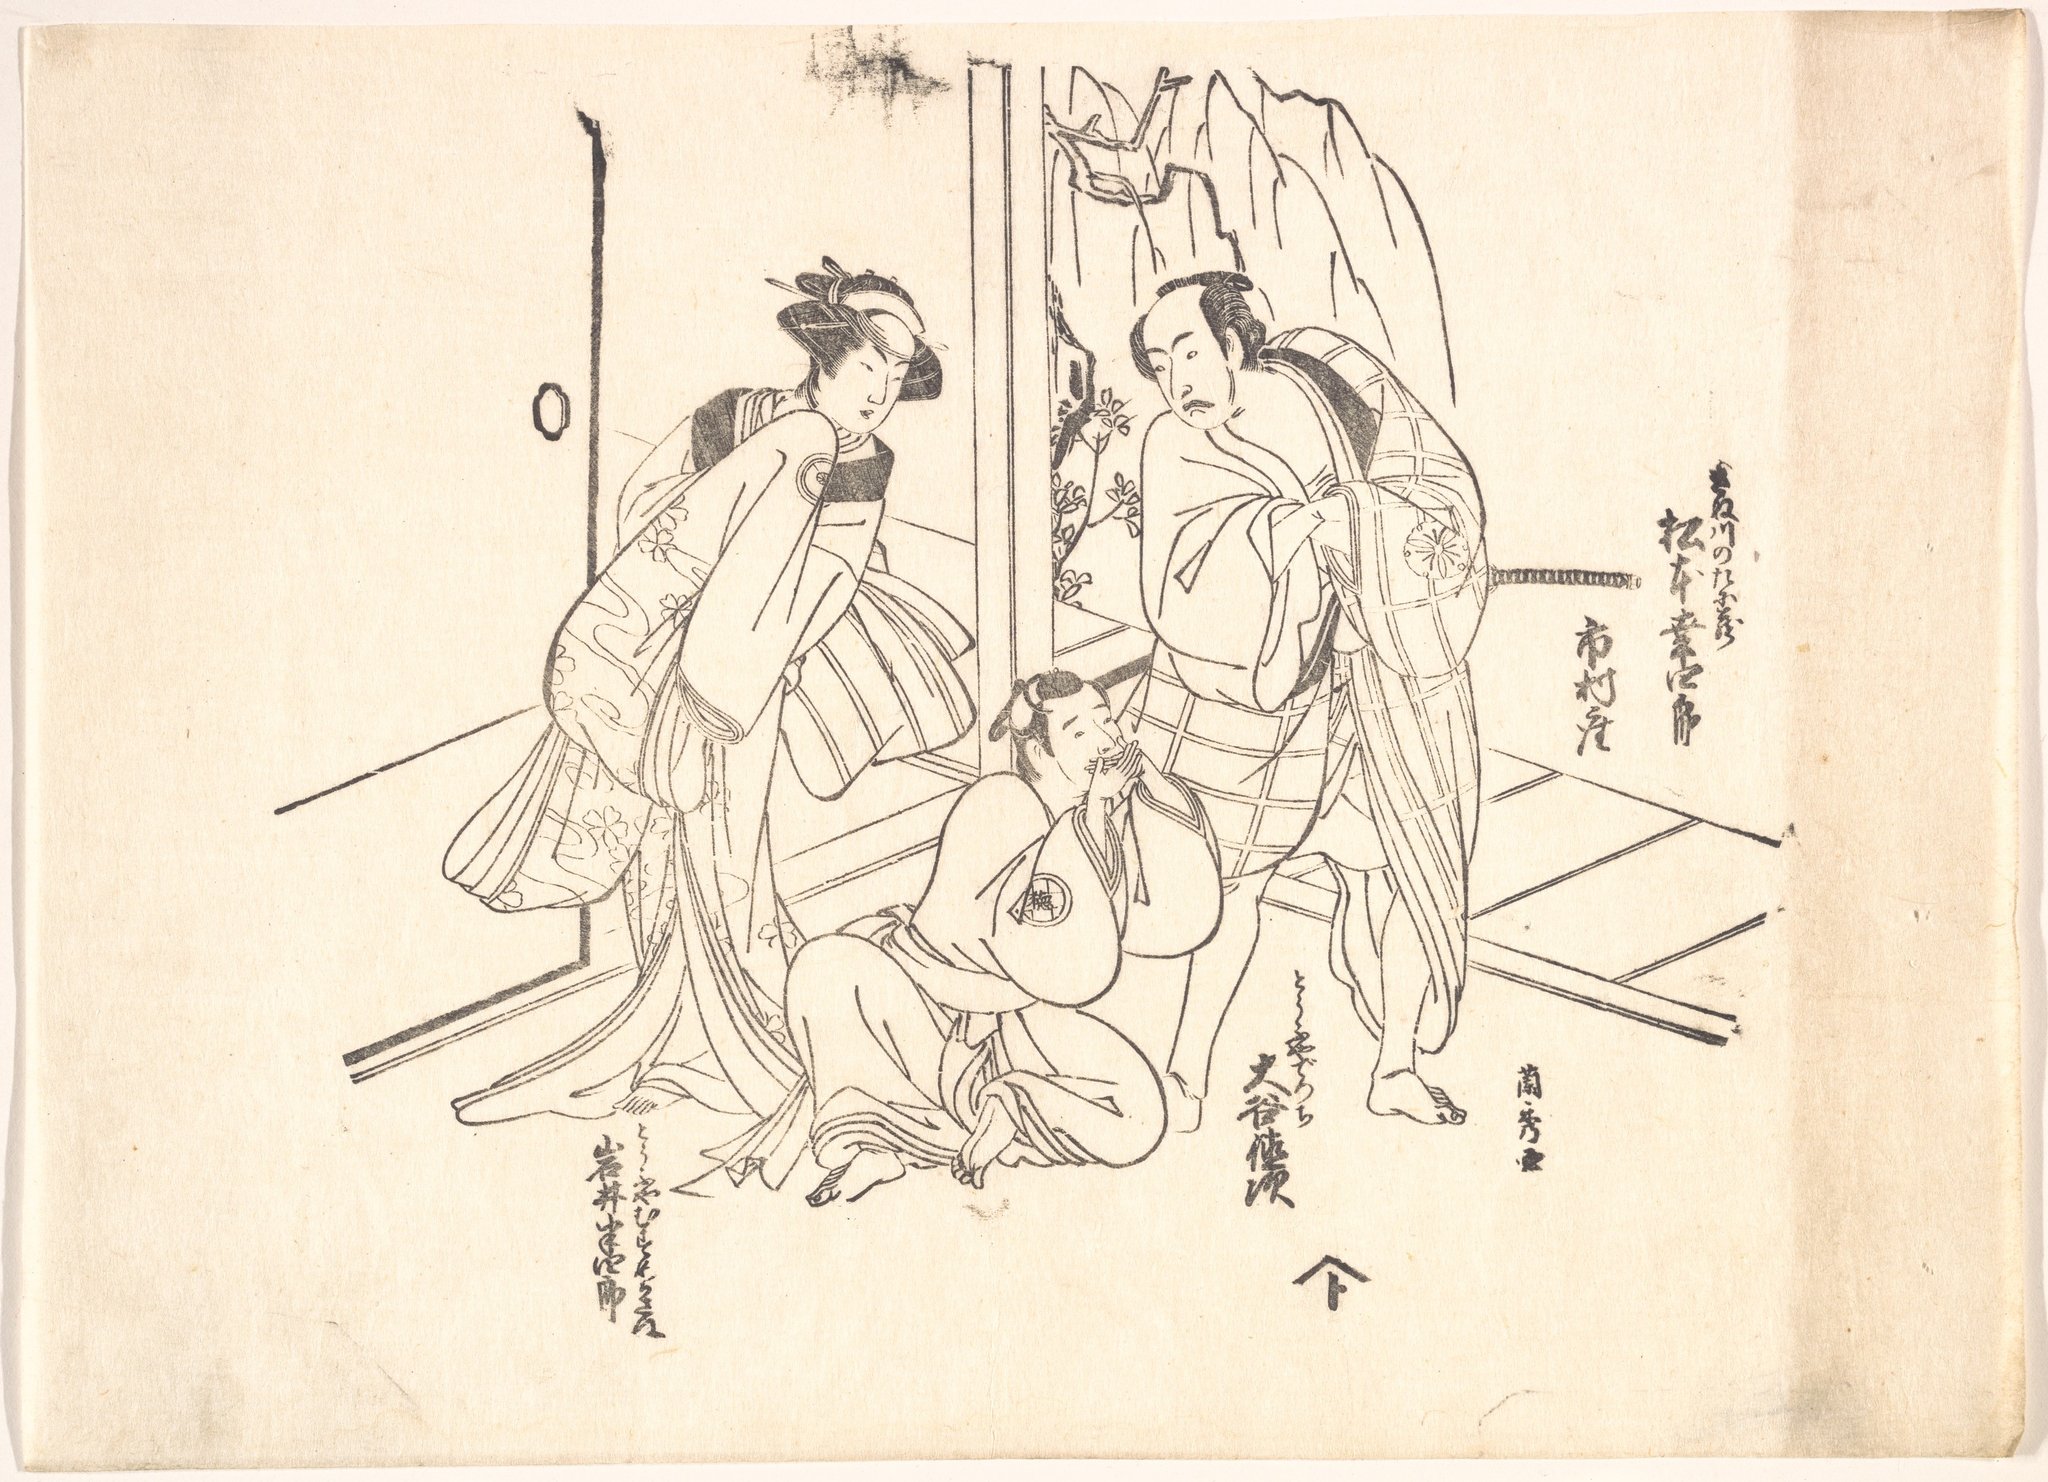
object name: woodblock print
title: Scene from a Drama: Matsumoto Koshiro I and Two Other Actors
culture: japanese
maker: ranshu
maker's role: artist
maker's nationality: japanese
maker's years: 18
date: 1750-1799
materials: ink, paper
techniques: woodblock print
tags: men,women,actors